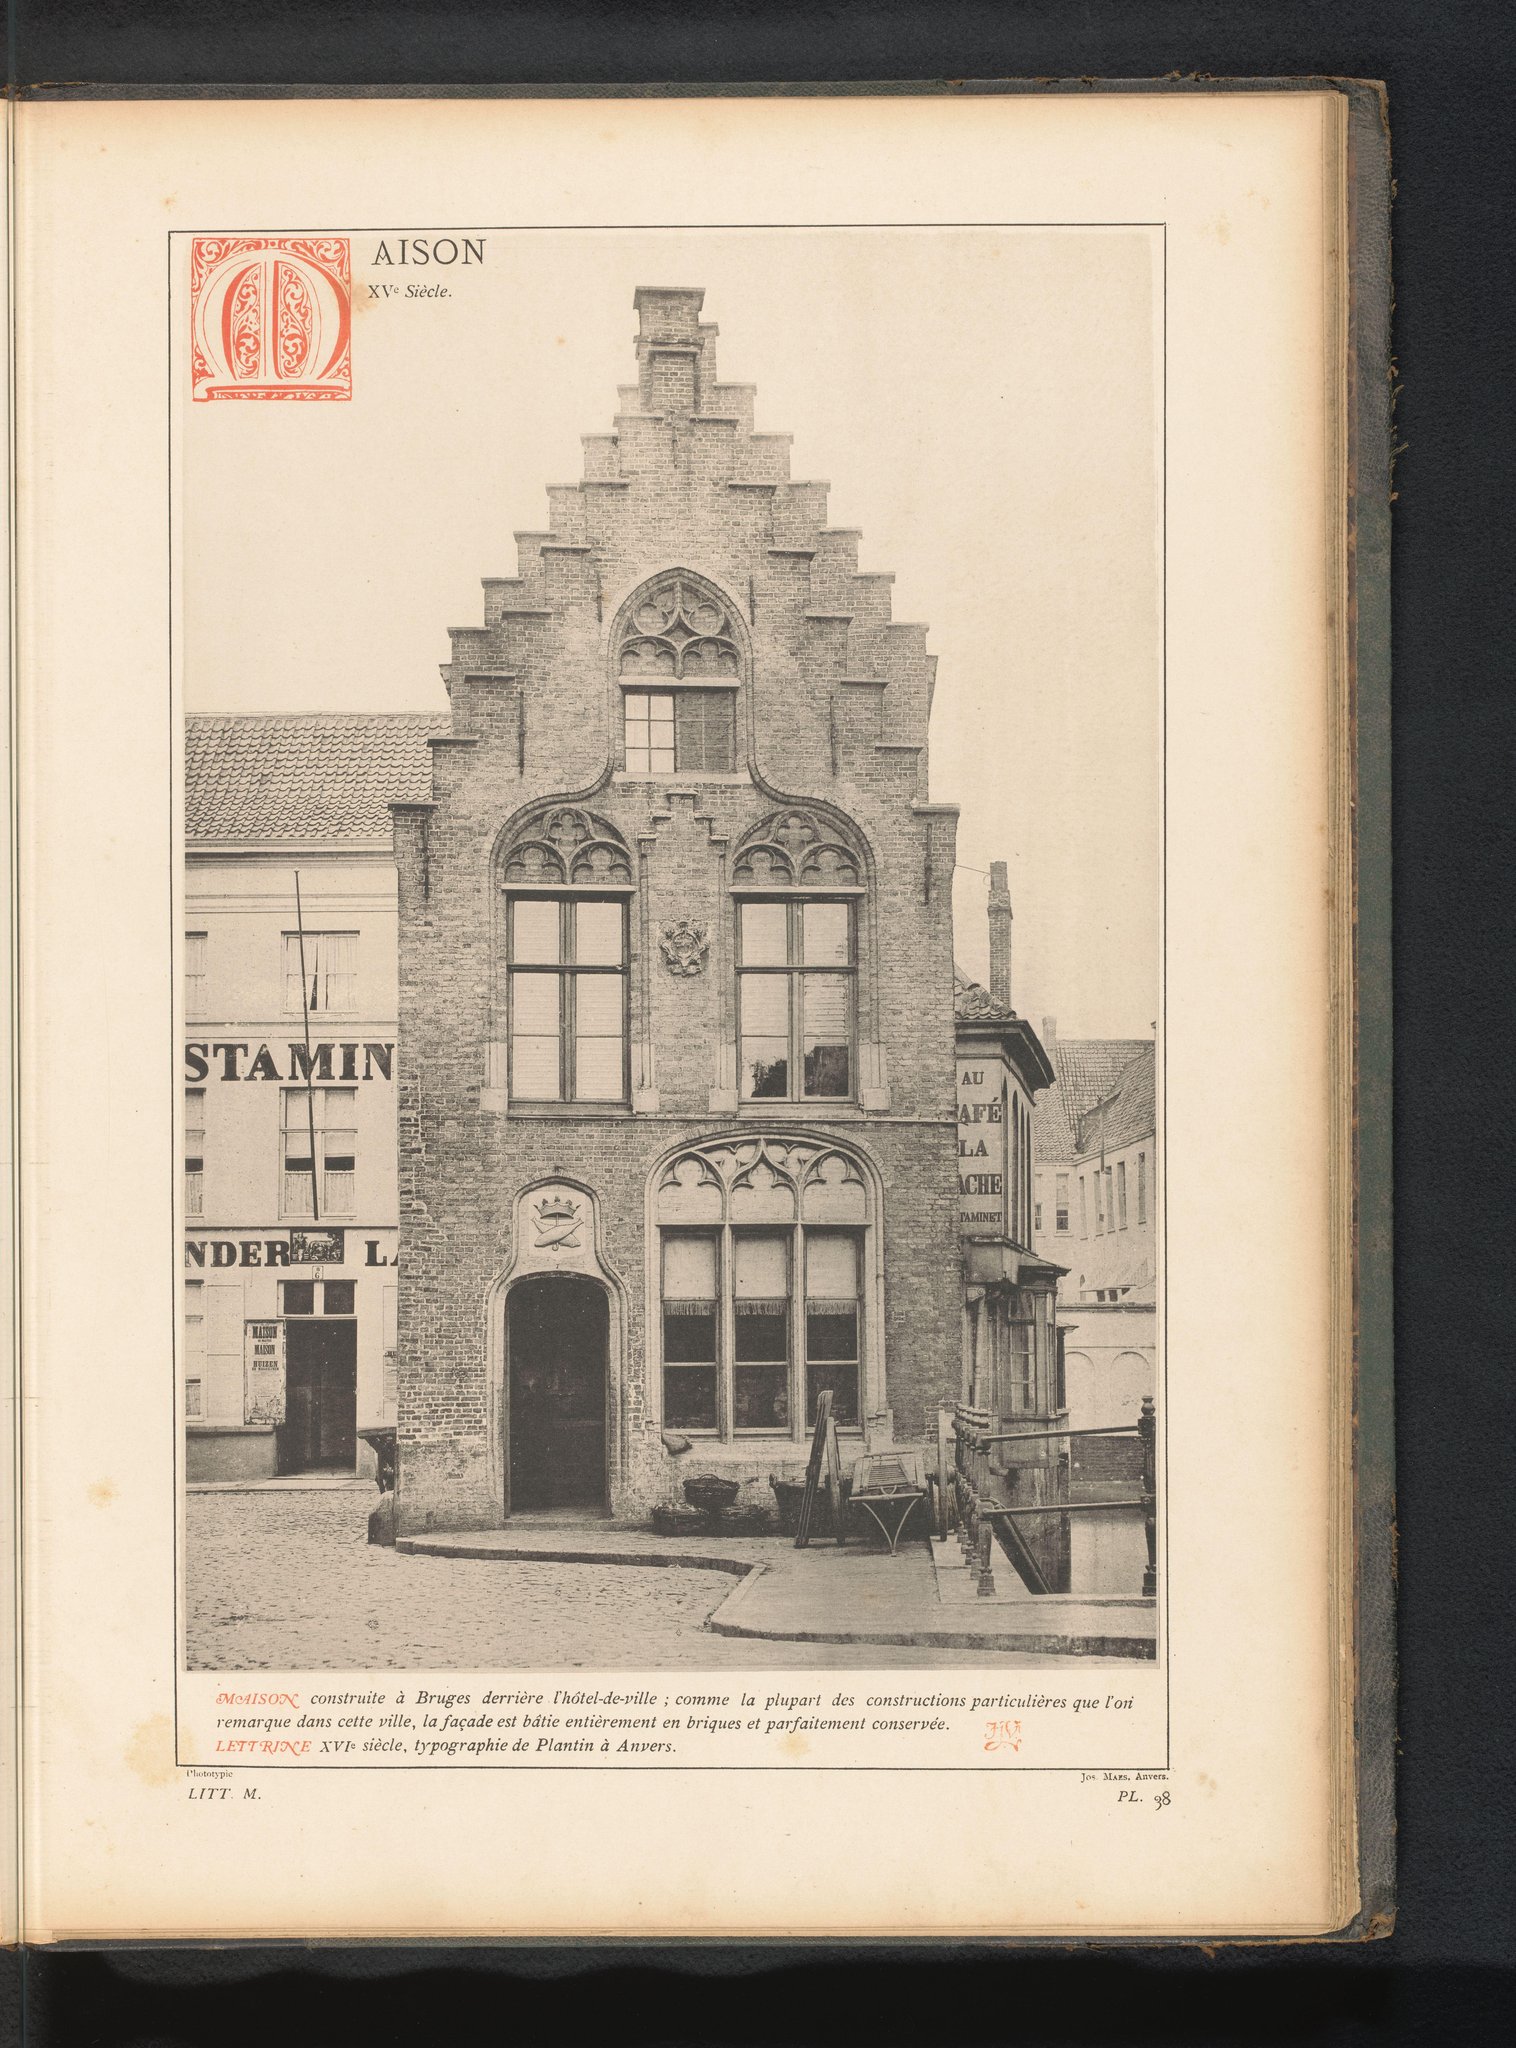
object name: photomechanical print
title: Gezicht op een huis in Brugge, België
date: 1875-1880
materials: paper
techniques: photograph, photolithography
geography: bruges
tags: civic architecture; edifices; dwellings, bruges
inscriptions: inscription: ‘LITT. M. - PL. 38’, inscription: ‘MAISON construite à (...)’, monogram: ‘JJvY’